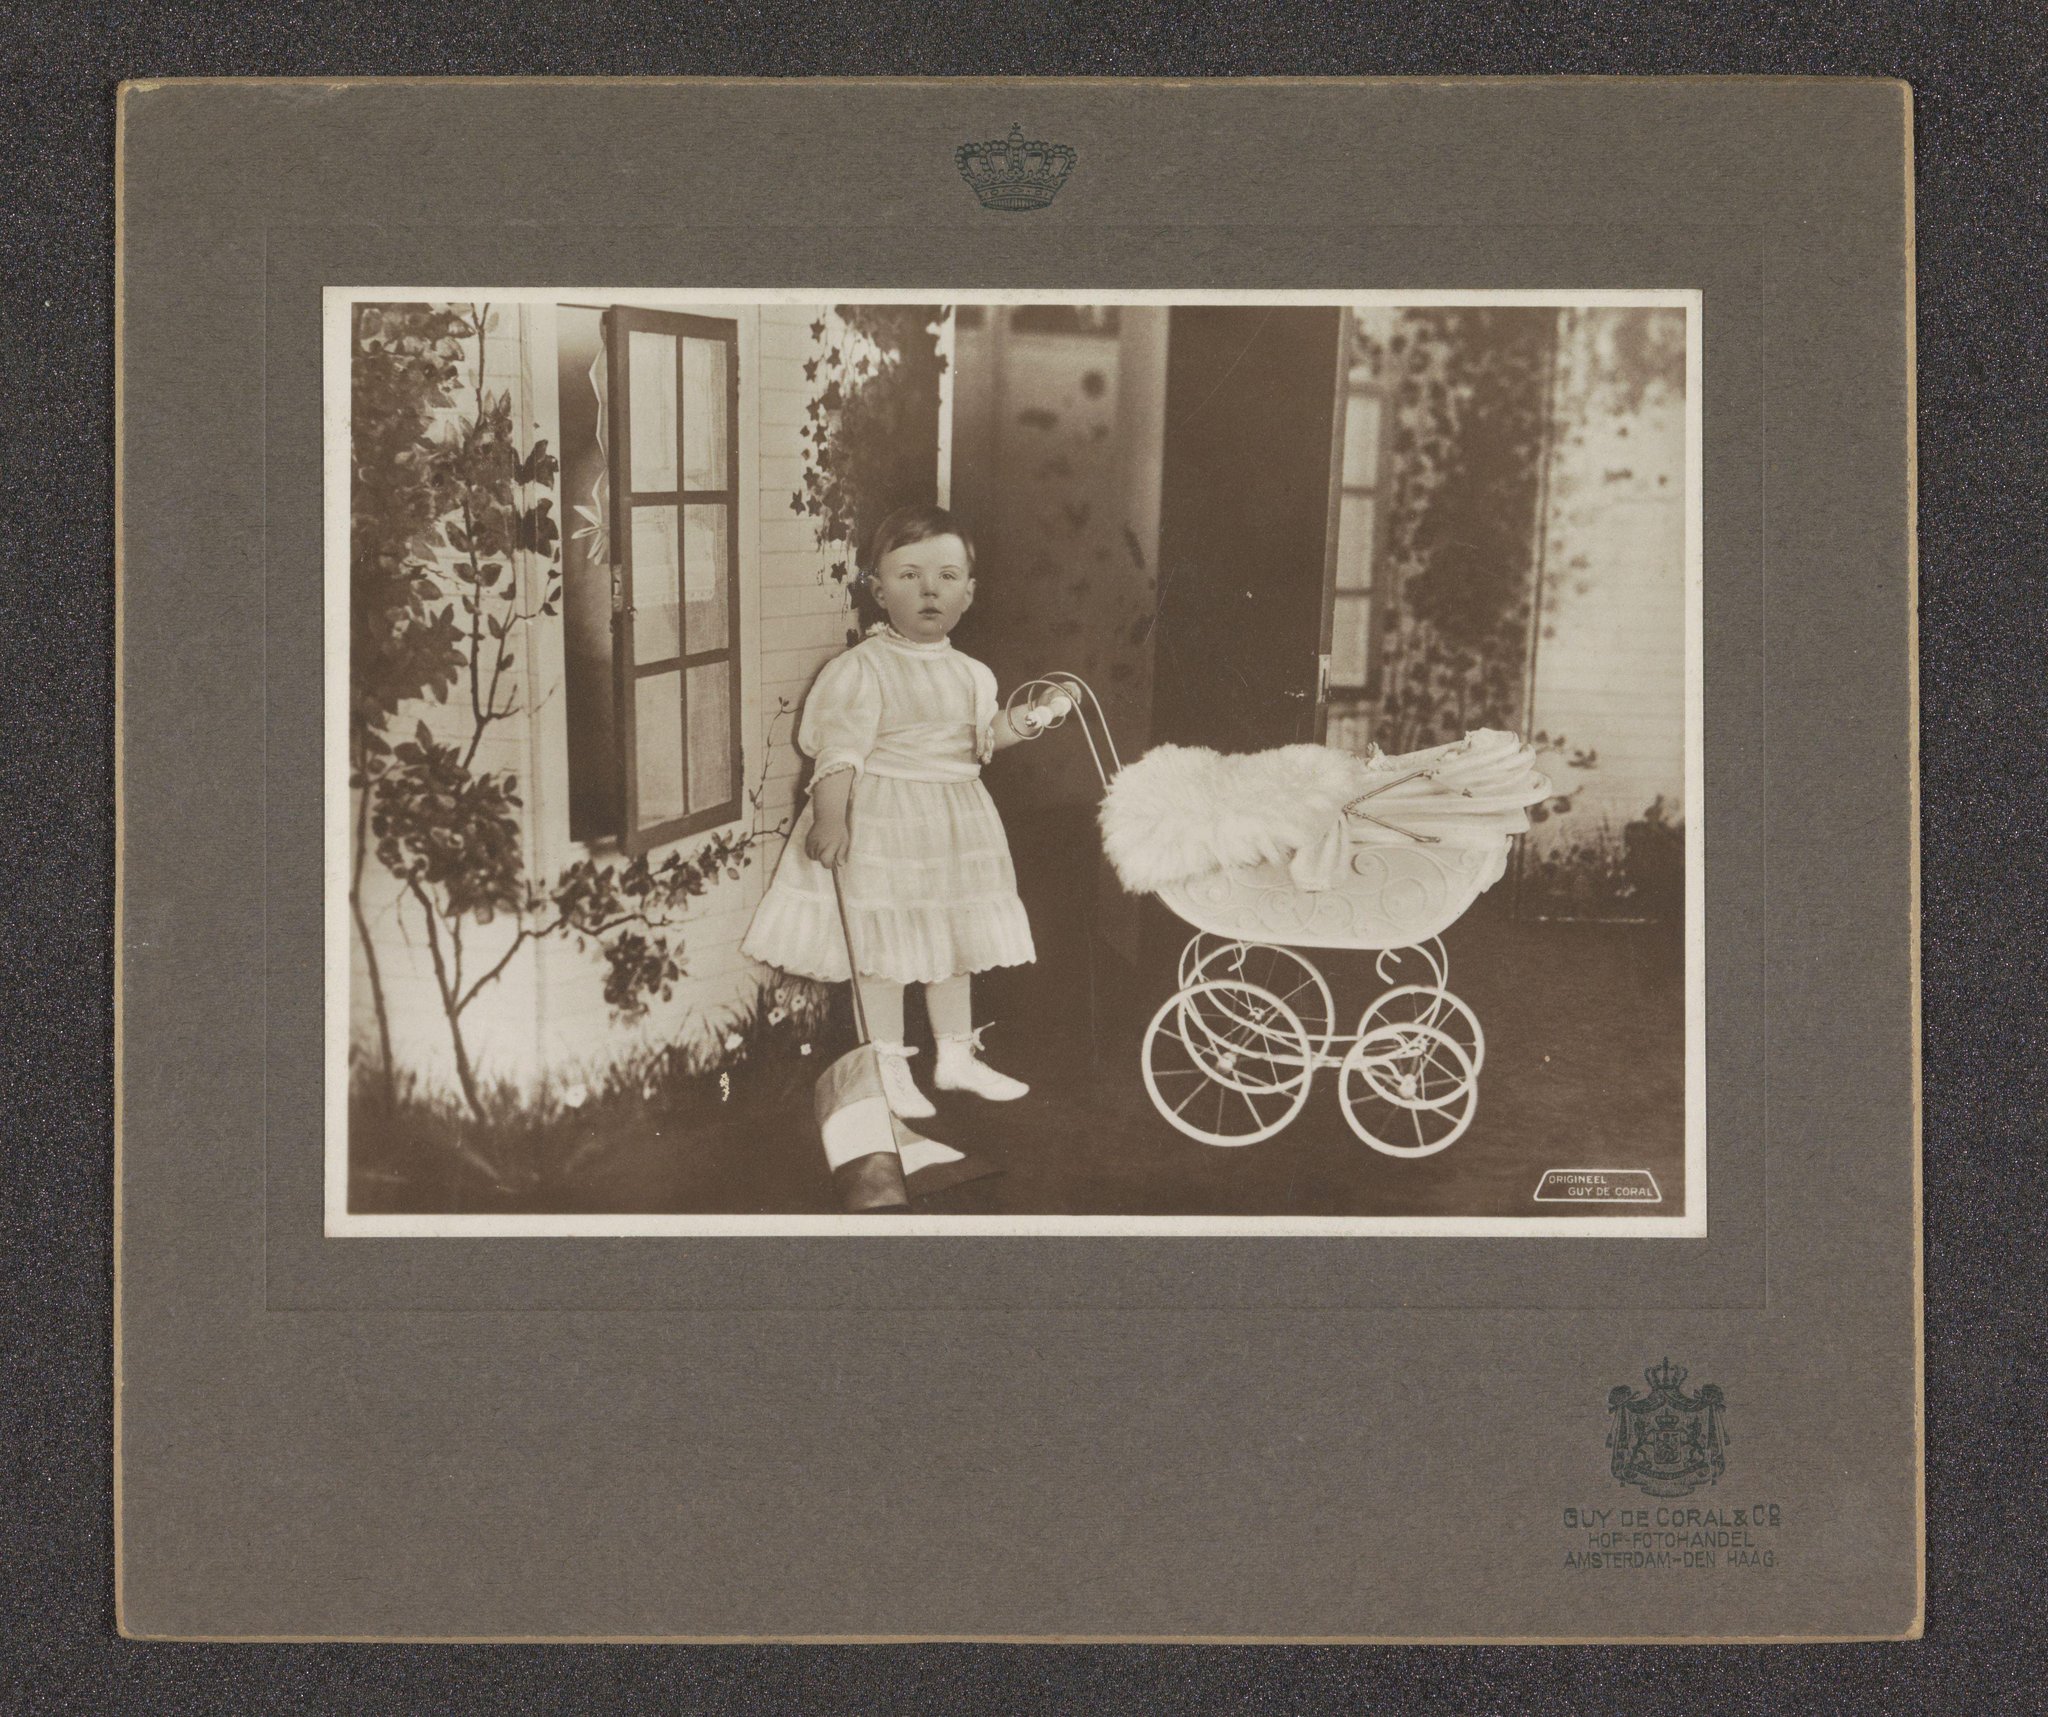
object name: photograph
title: Kinderportret van Prinses Juliana bij een poppenwagen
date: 1912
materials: cardboard, paper, photographic support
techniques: gelatin silver print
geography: amsterdam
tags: juliana of the netherlands, the hague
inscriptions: stamp: ‘Guy de Coral Hof - fotohandel Amsterdam - Den Haag’